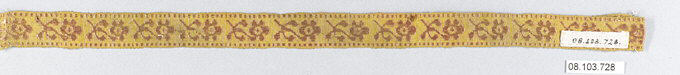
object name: galloon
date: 1834-1866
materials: silk